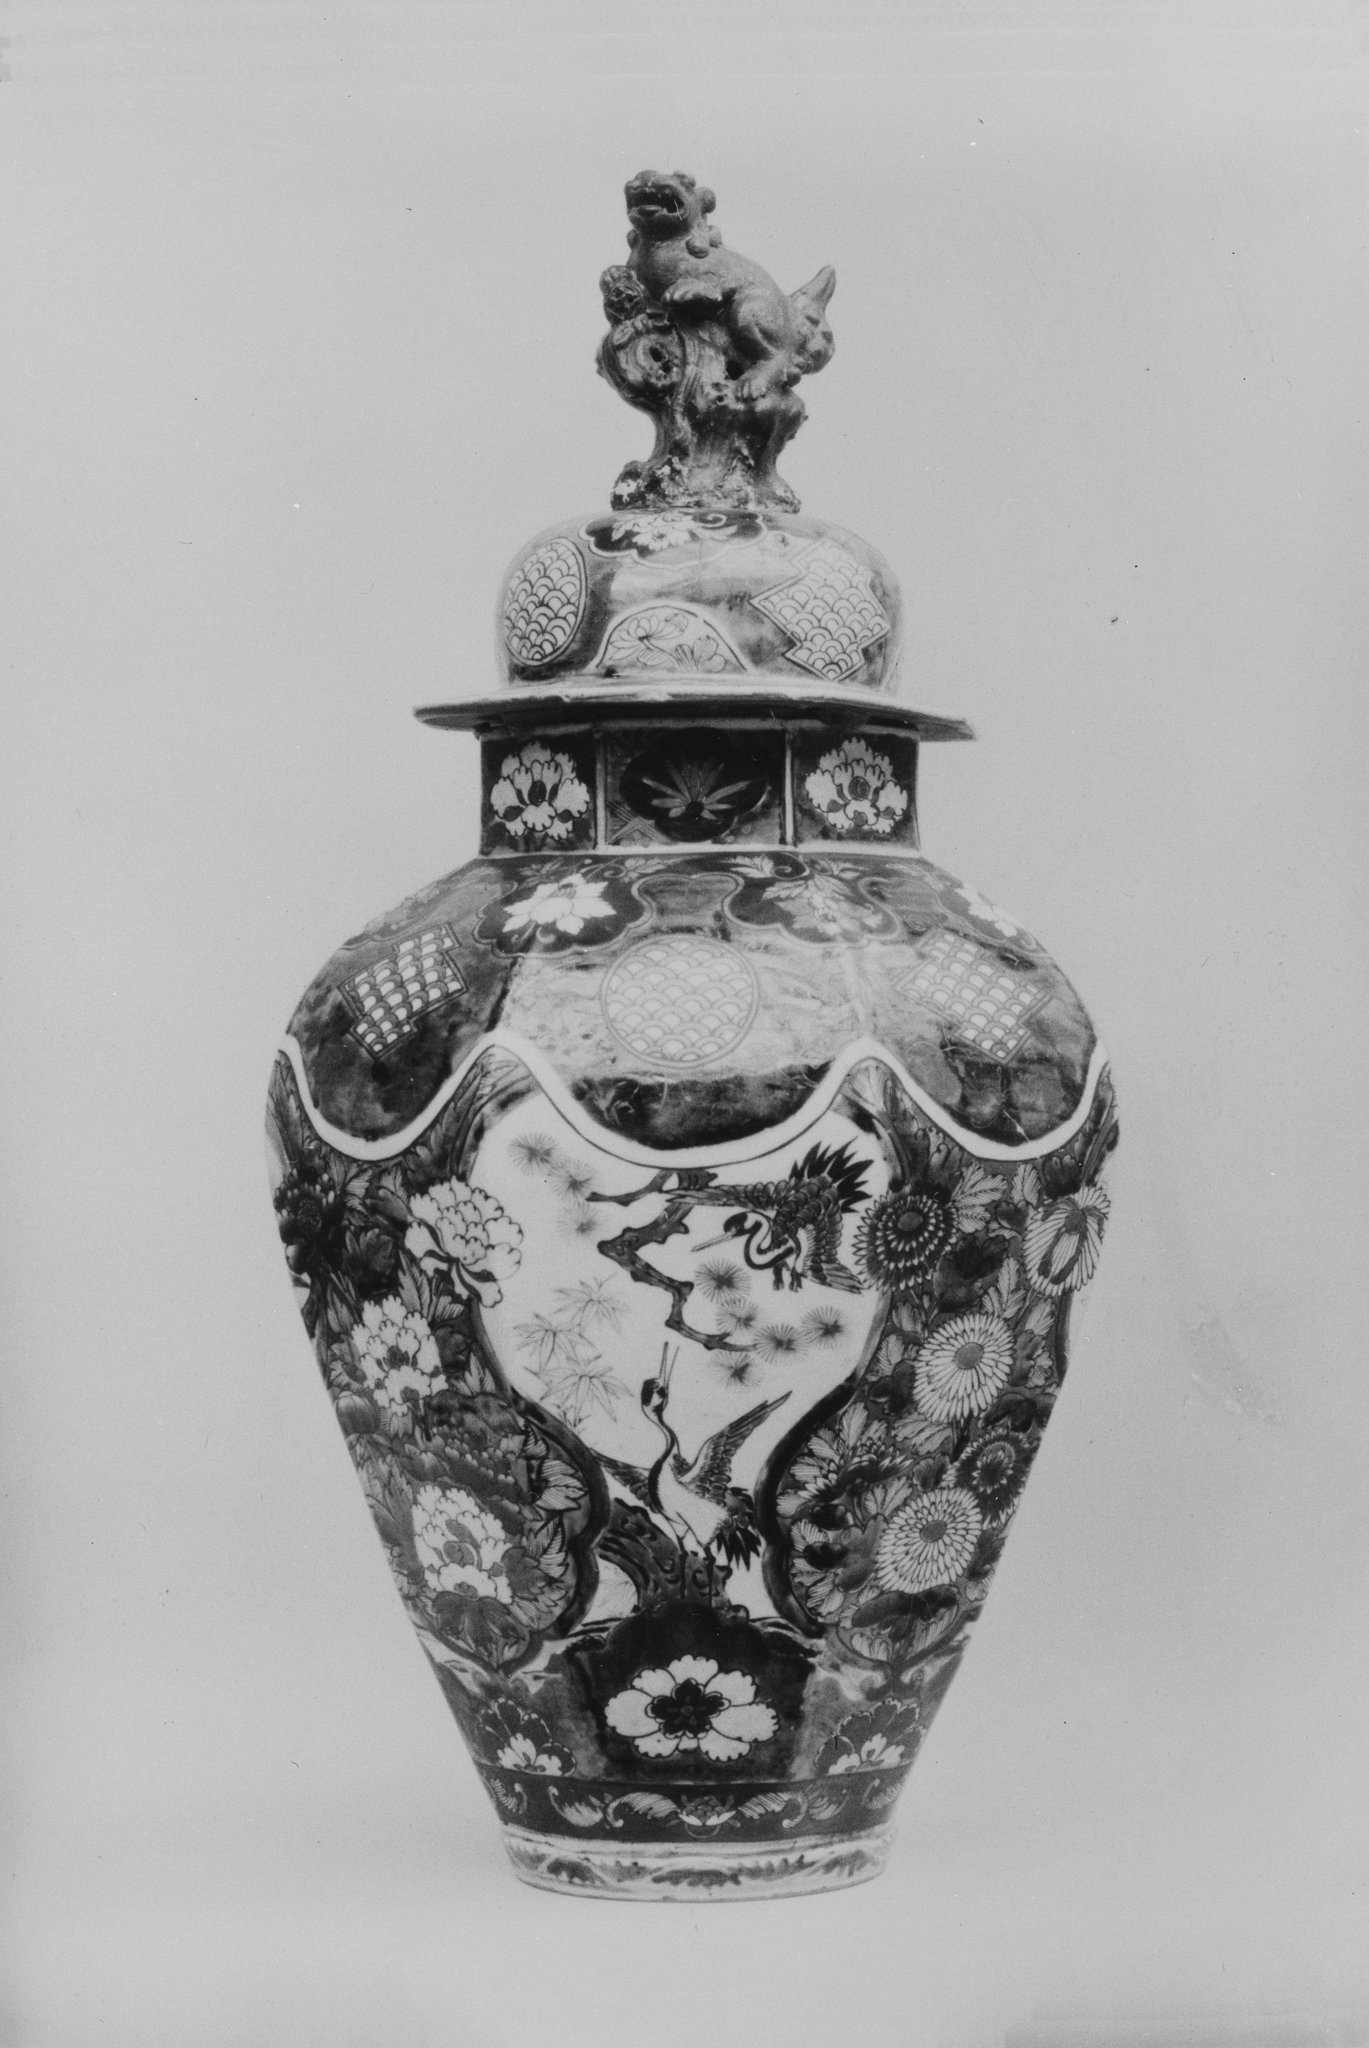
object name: jar with cover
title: Octagonal Jar with Cover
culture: japanese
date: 1700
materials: enamel, glaze, gold, porcelain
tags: animals